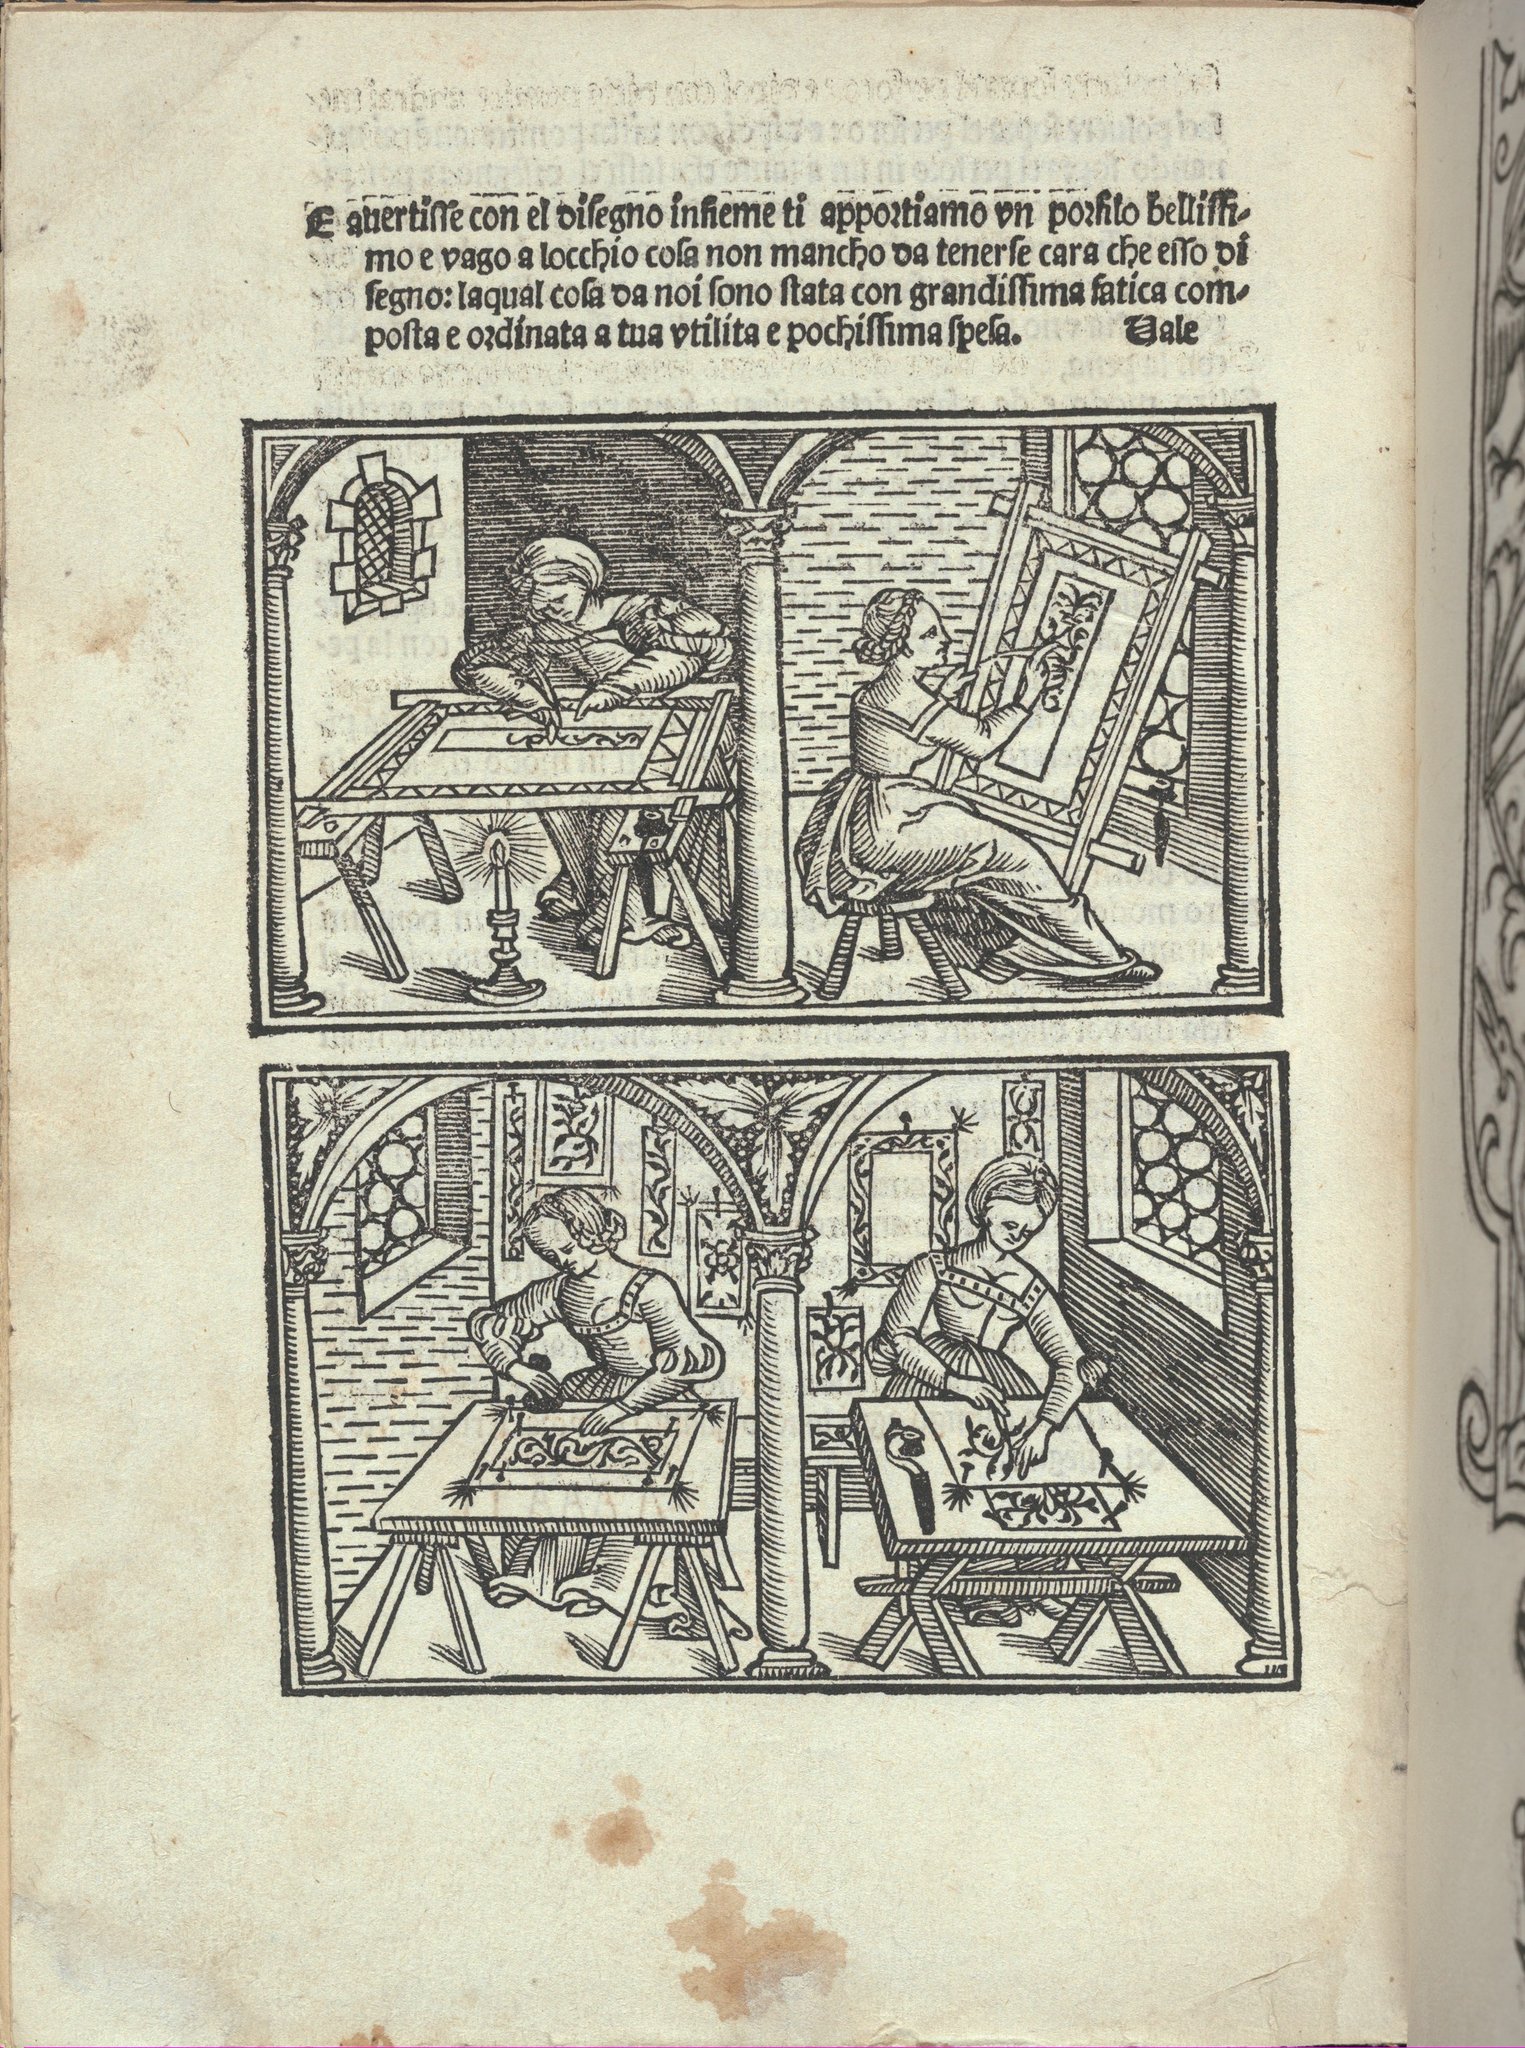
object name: book print ornament architecture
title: Libro quarto. De rechami per elquale se impara in diuersi modi lordine e il modo de recamare...Opera noua, page 2 (verso)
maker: alessandro paganino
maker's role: publisher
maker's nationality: italian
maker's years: 1500-1550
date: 1532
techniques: woodcut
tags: painting,women